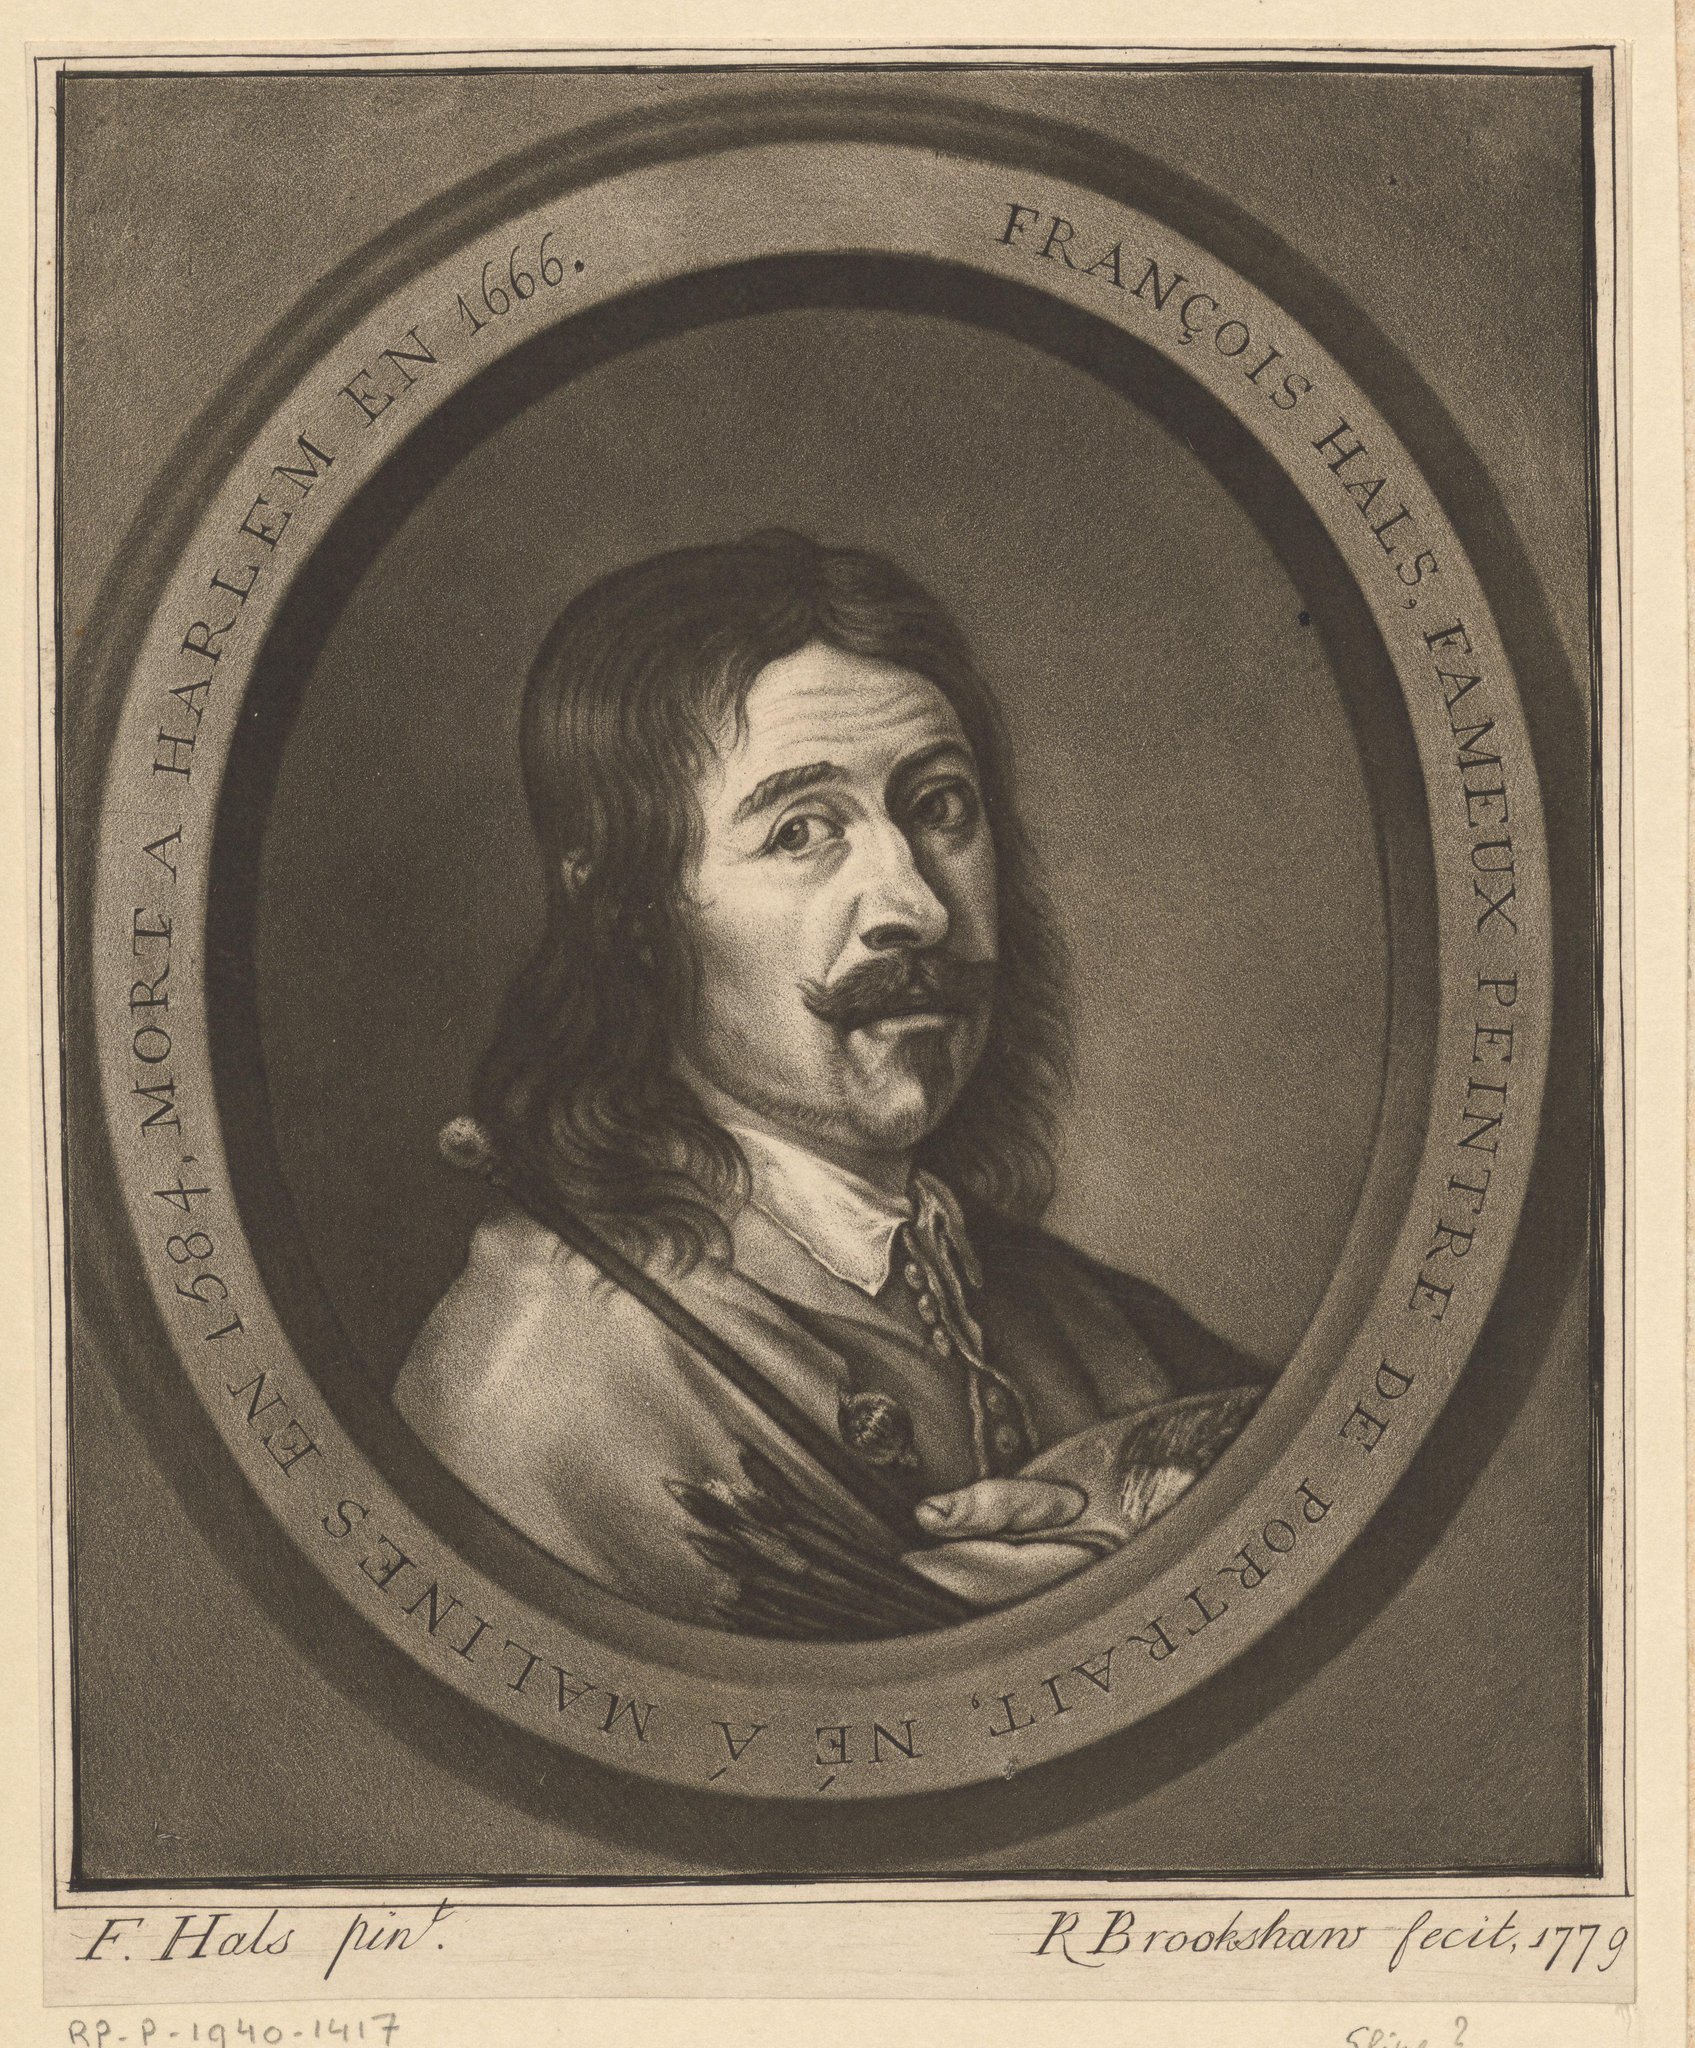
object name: print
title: Portret van Frans Hals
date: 1779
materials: paper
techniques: engraving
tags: antwerp, haarlem, draughtsman, frans hals, historical persons, portrait, self-portrait of painter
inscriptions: collector's mark: Lugt 2166, collector's mark: Lugt 2760